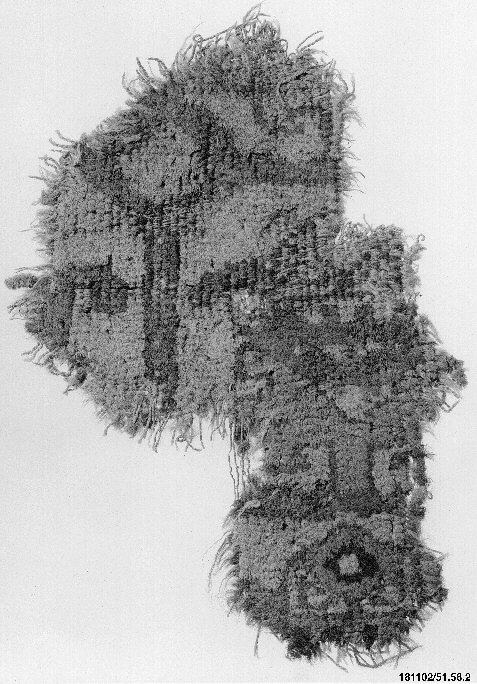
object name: carpet fragment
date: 801-1000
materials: wool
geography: egypt